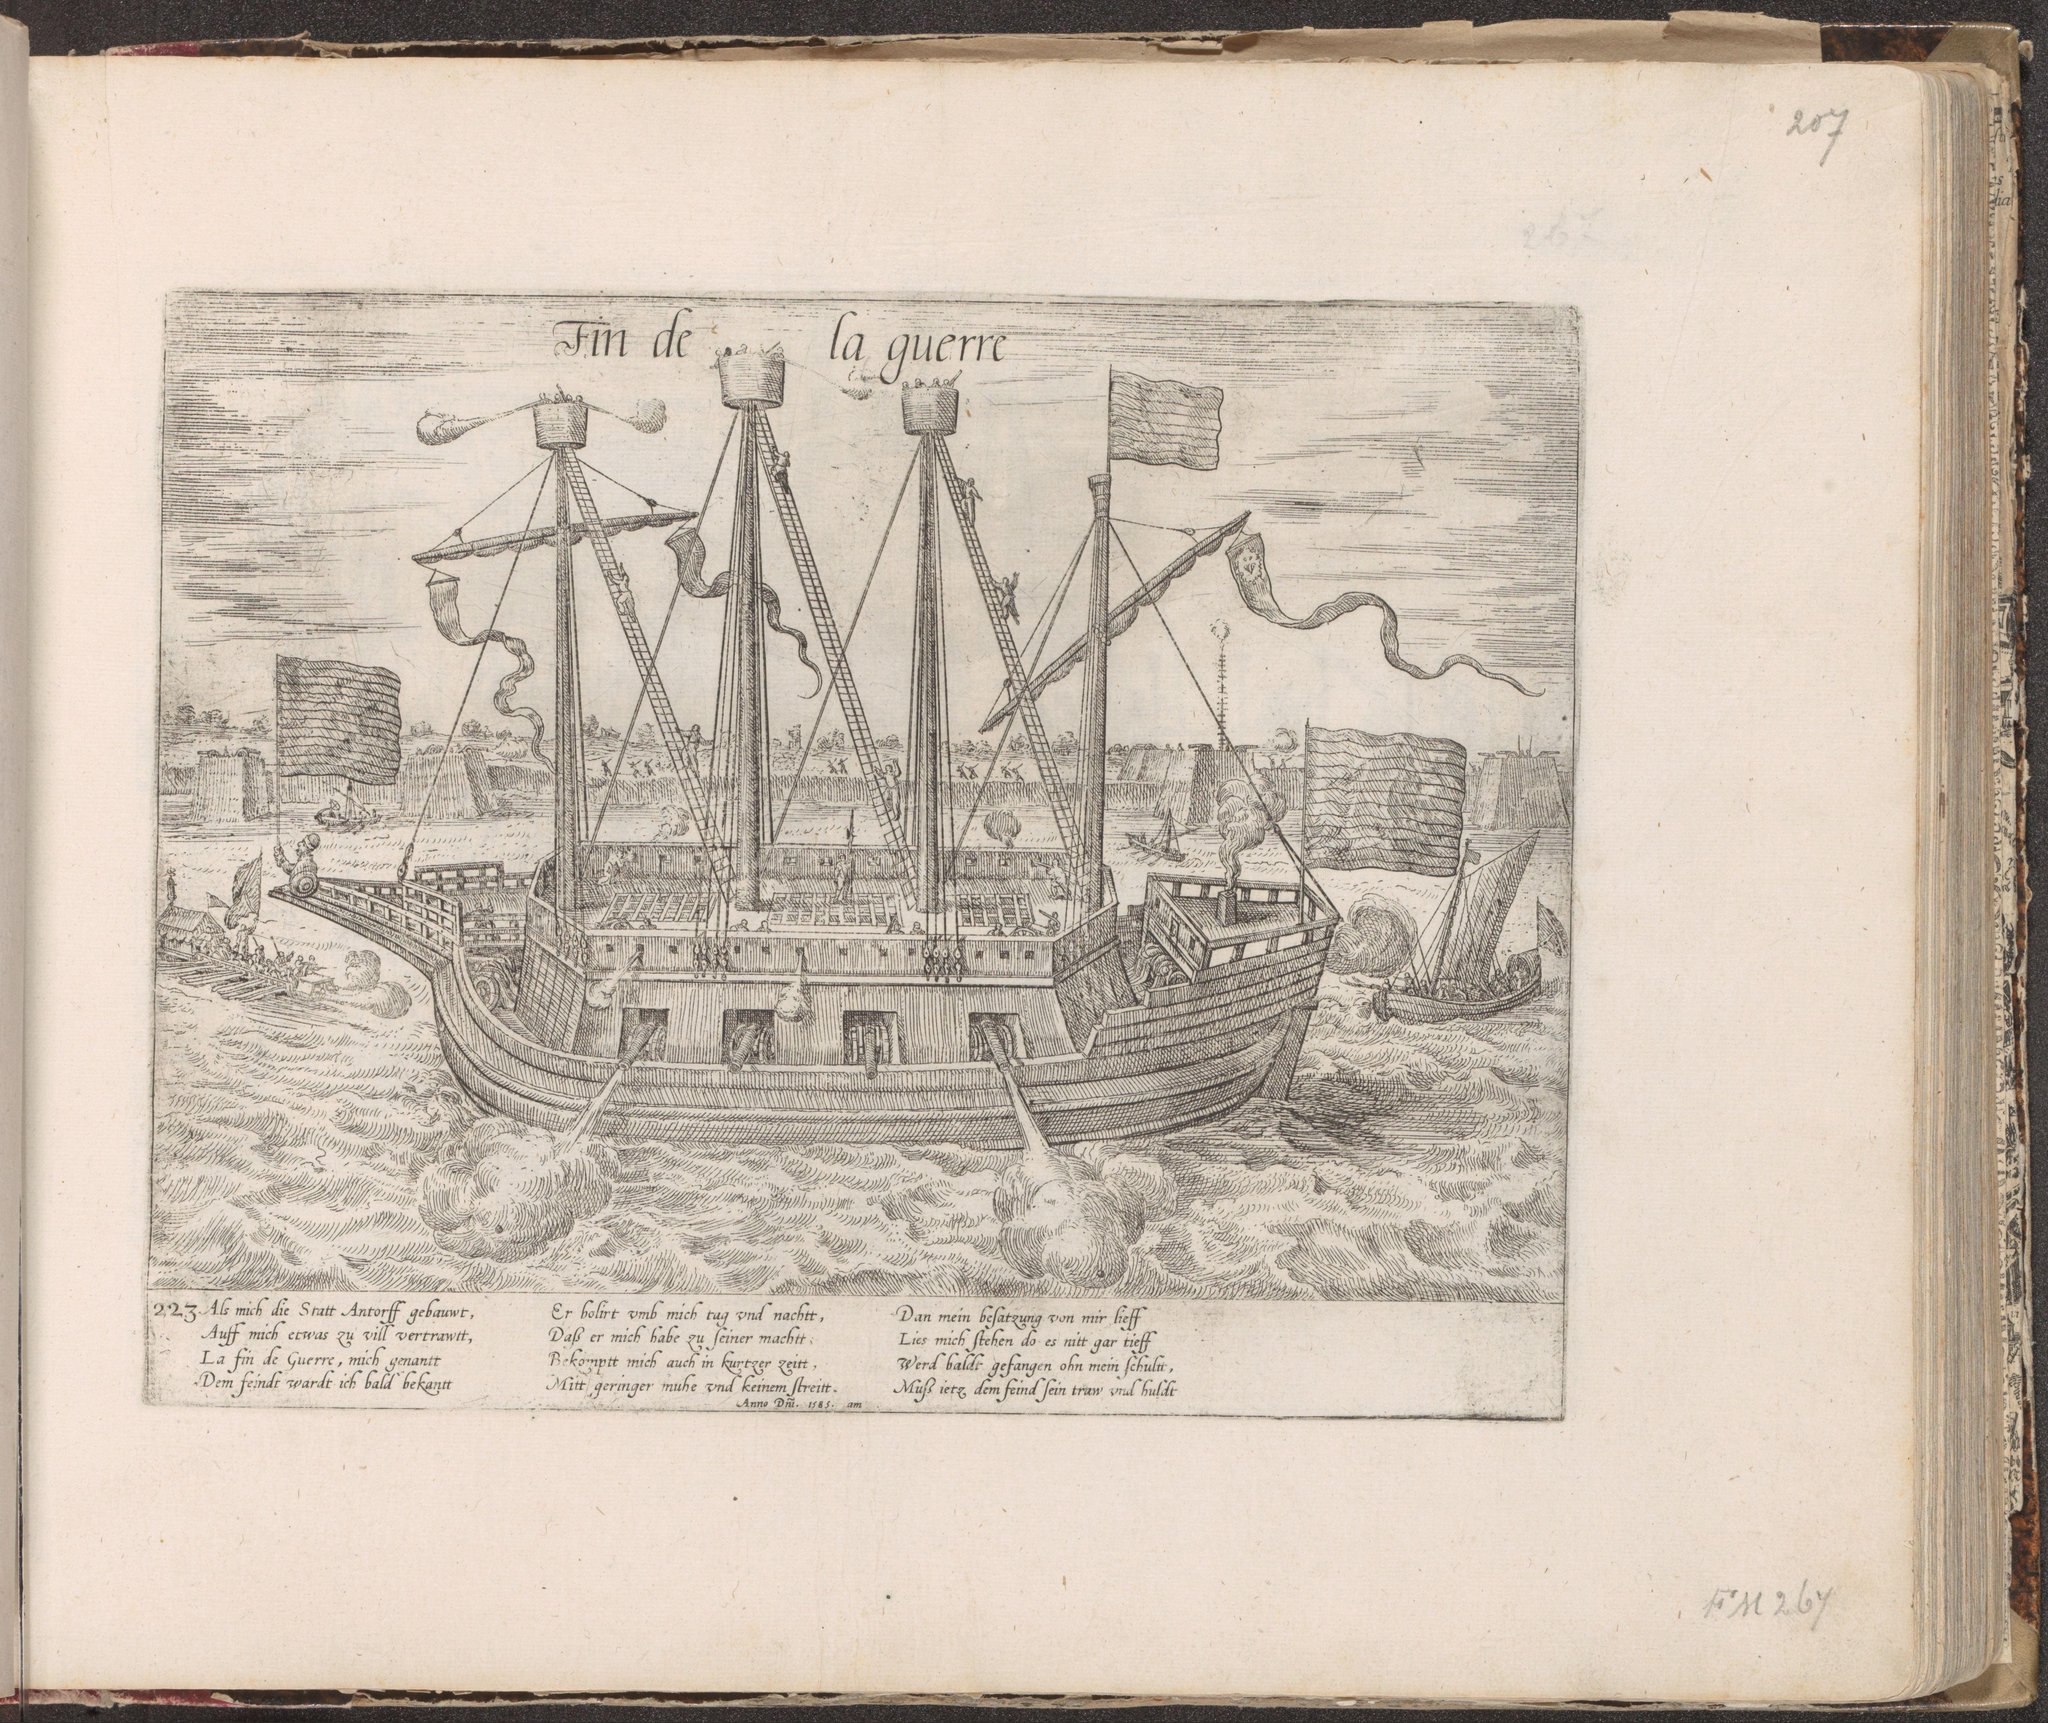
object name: history print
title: Het schip Fin de la guerre, 1585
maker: frans hogenberg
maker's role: print maker, publisher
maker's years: 1538-1590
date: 1587-1591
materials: paper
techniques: etching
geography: cologne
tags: warfare; military affairs (+ naval force), antwerp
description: Het enorme schip genaamd Fin de la guerre, gebouwd door de Antwerpenaren om de schipbrug van Parma te vernietigen, mei 1585. Met onderschrift van 12 regels in het Duits. Linksonder genummerd: 223. De prent maakt deel uit van een album.